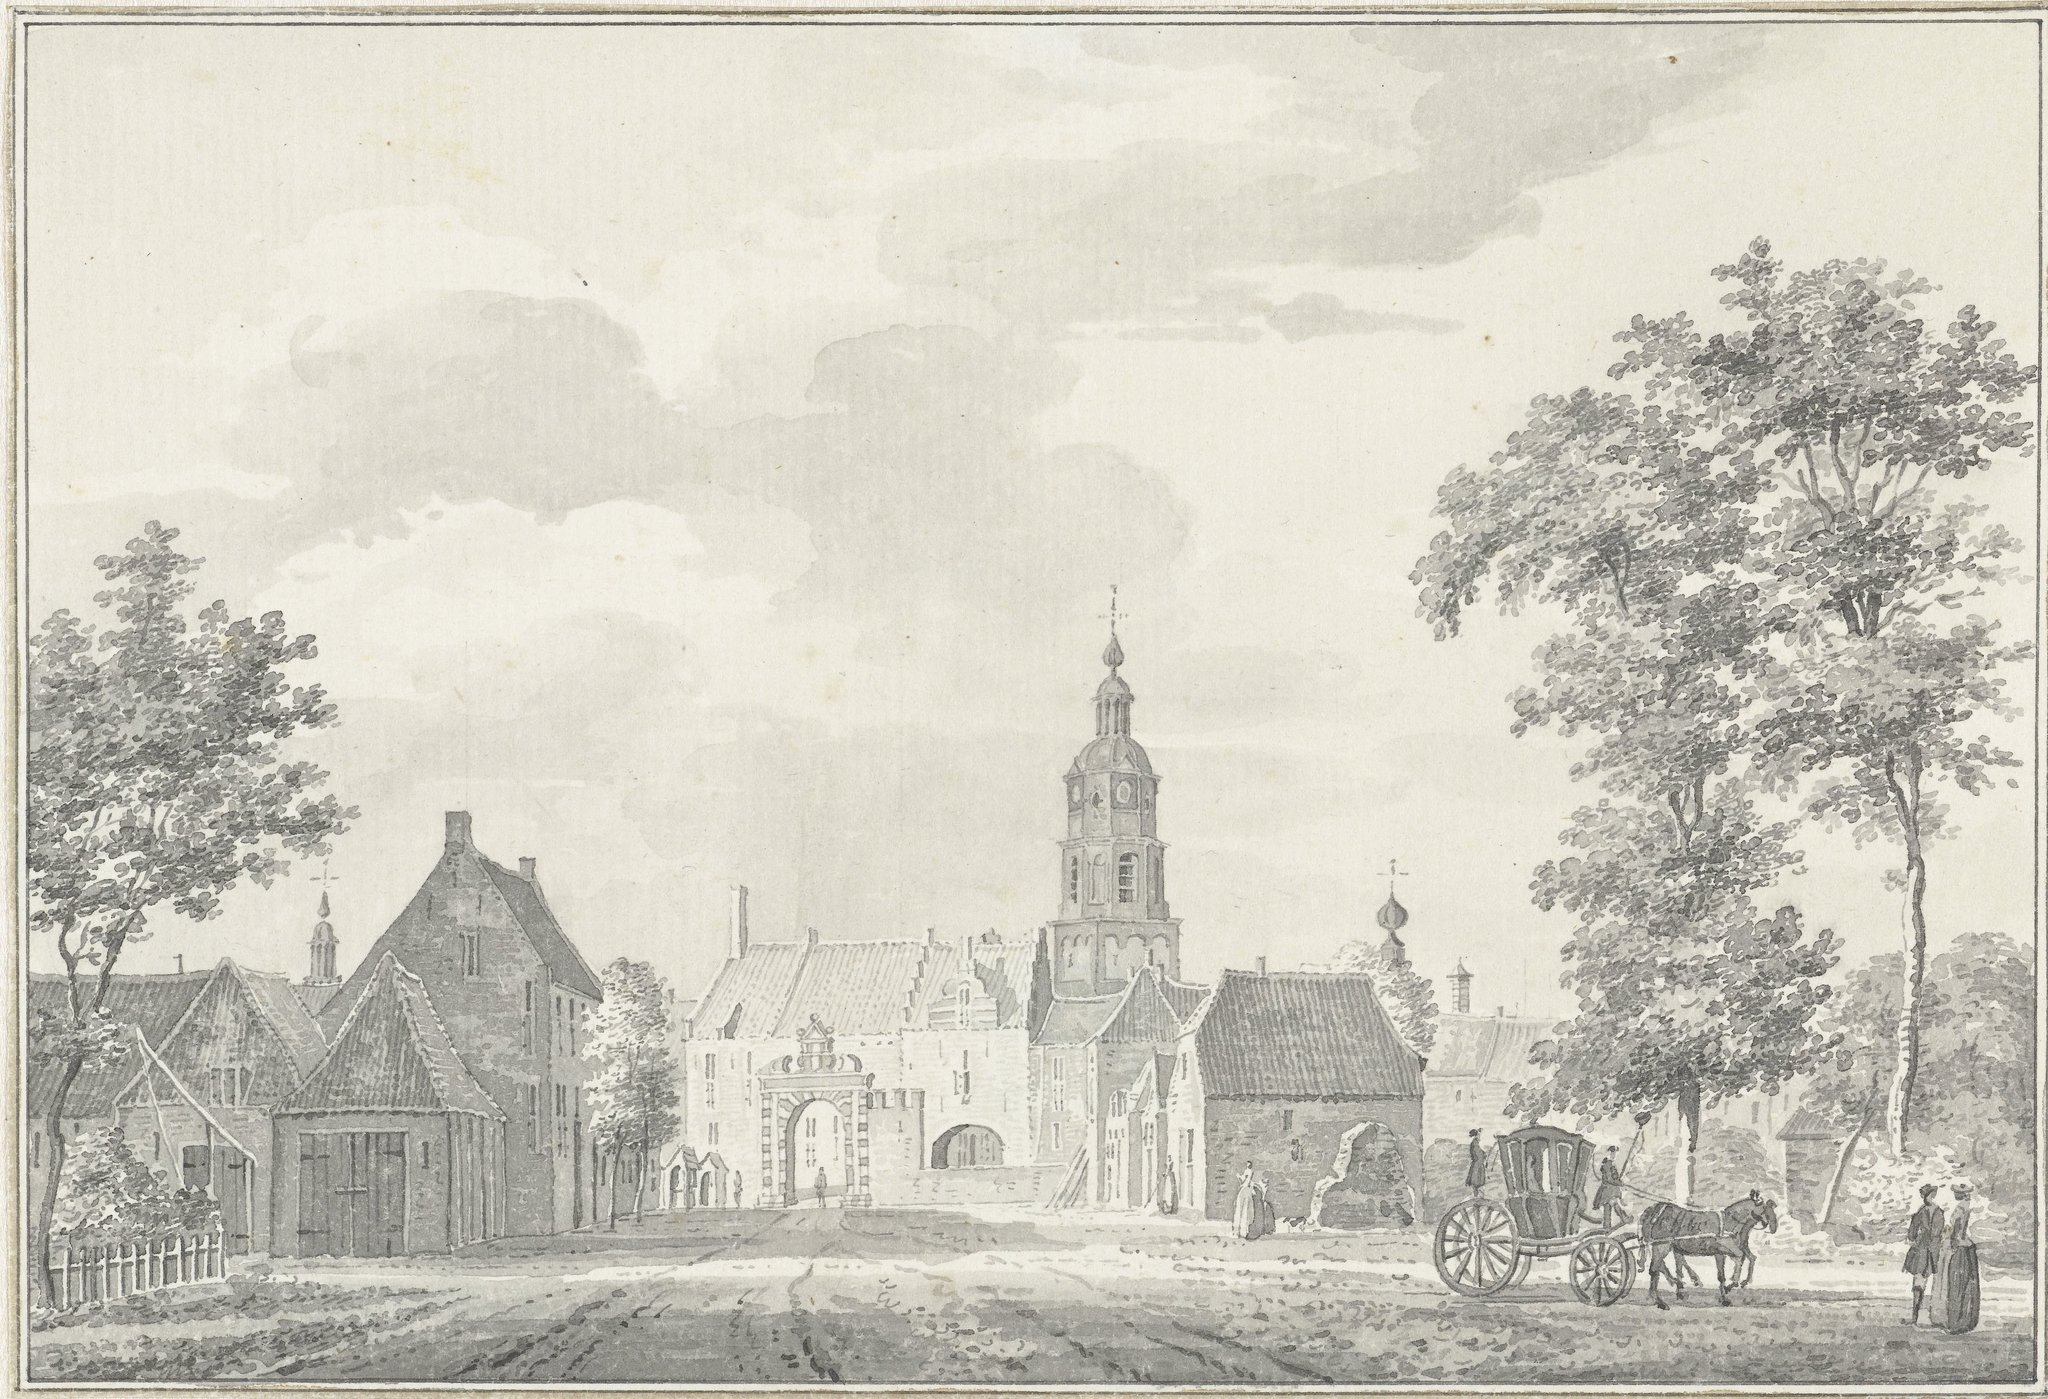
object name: drawing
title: Gezicht op een van de stadspoorten van Buren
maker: pieter jan van liender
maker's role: print maker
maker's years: 1727-1779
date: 1750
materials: ink, paper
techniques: brush, pen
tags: city-gate, buren